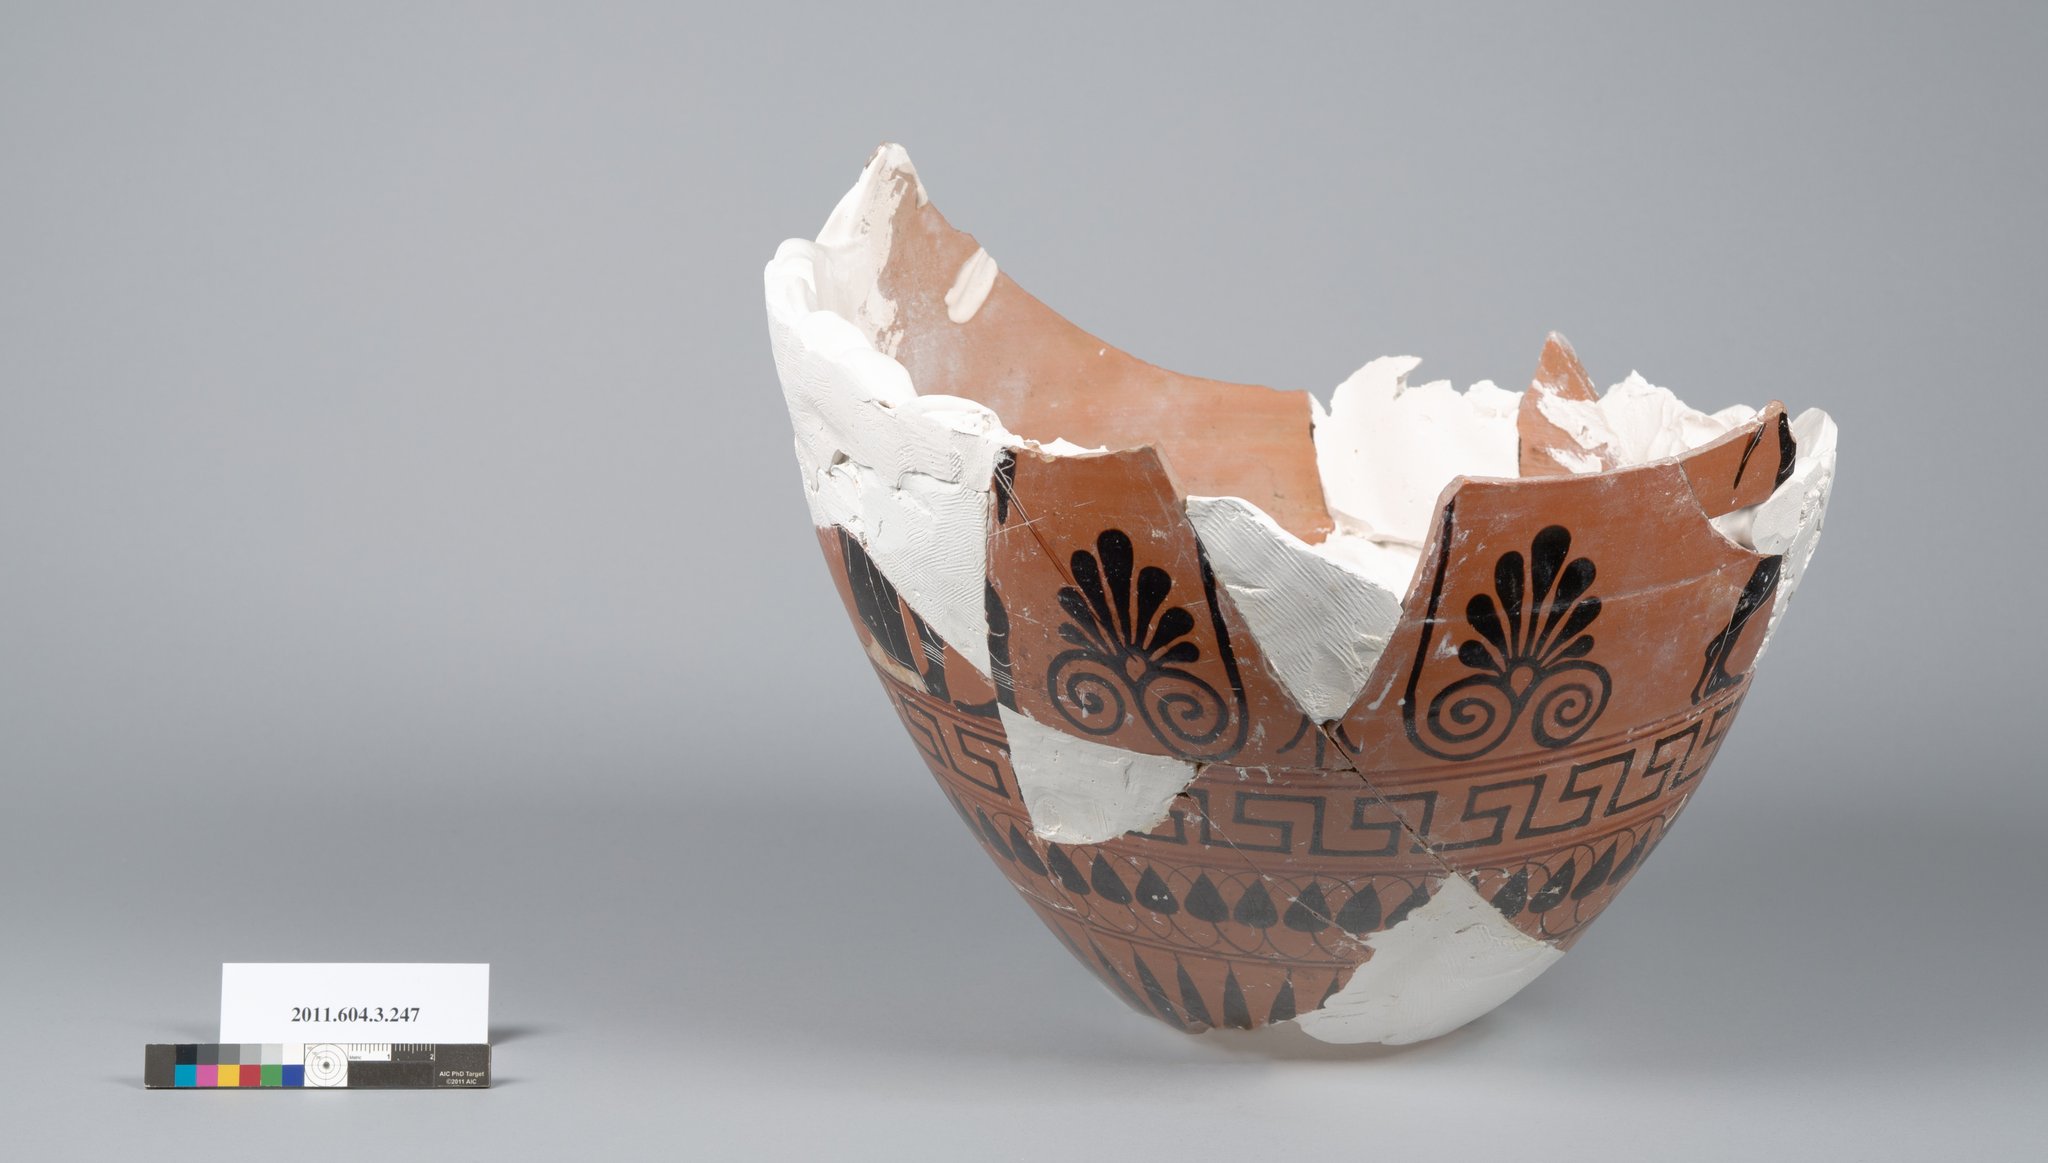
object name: neck amphora fragment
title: Terracotta fragment of a neck-amphora (jar)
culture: greek, attic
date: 540-530 BCE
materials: terracotta